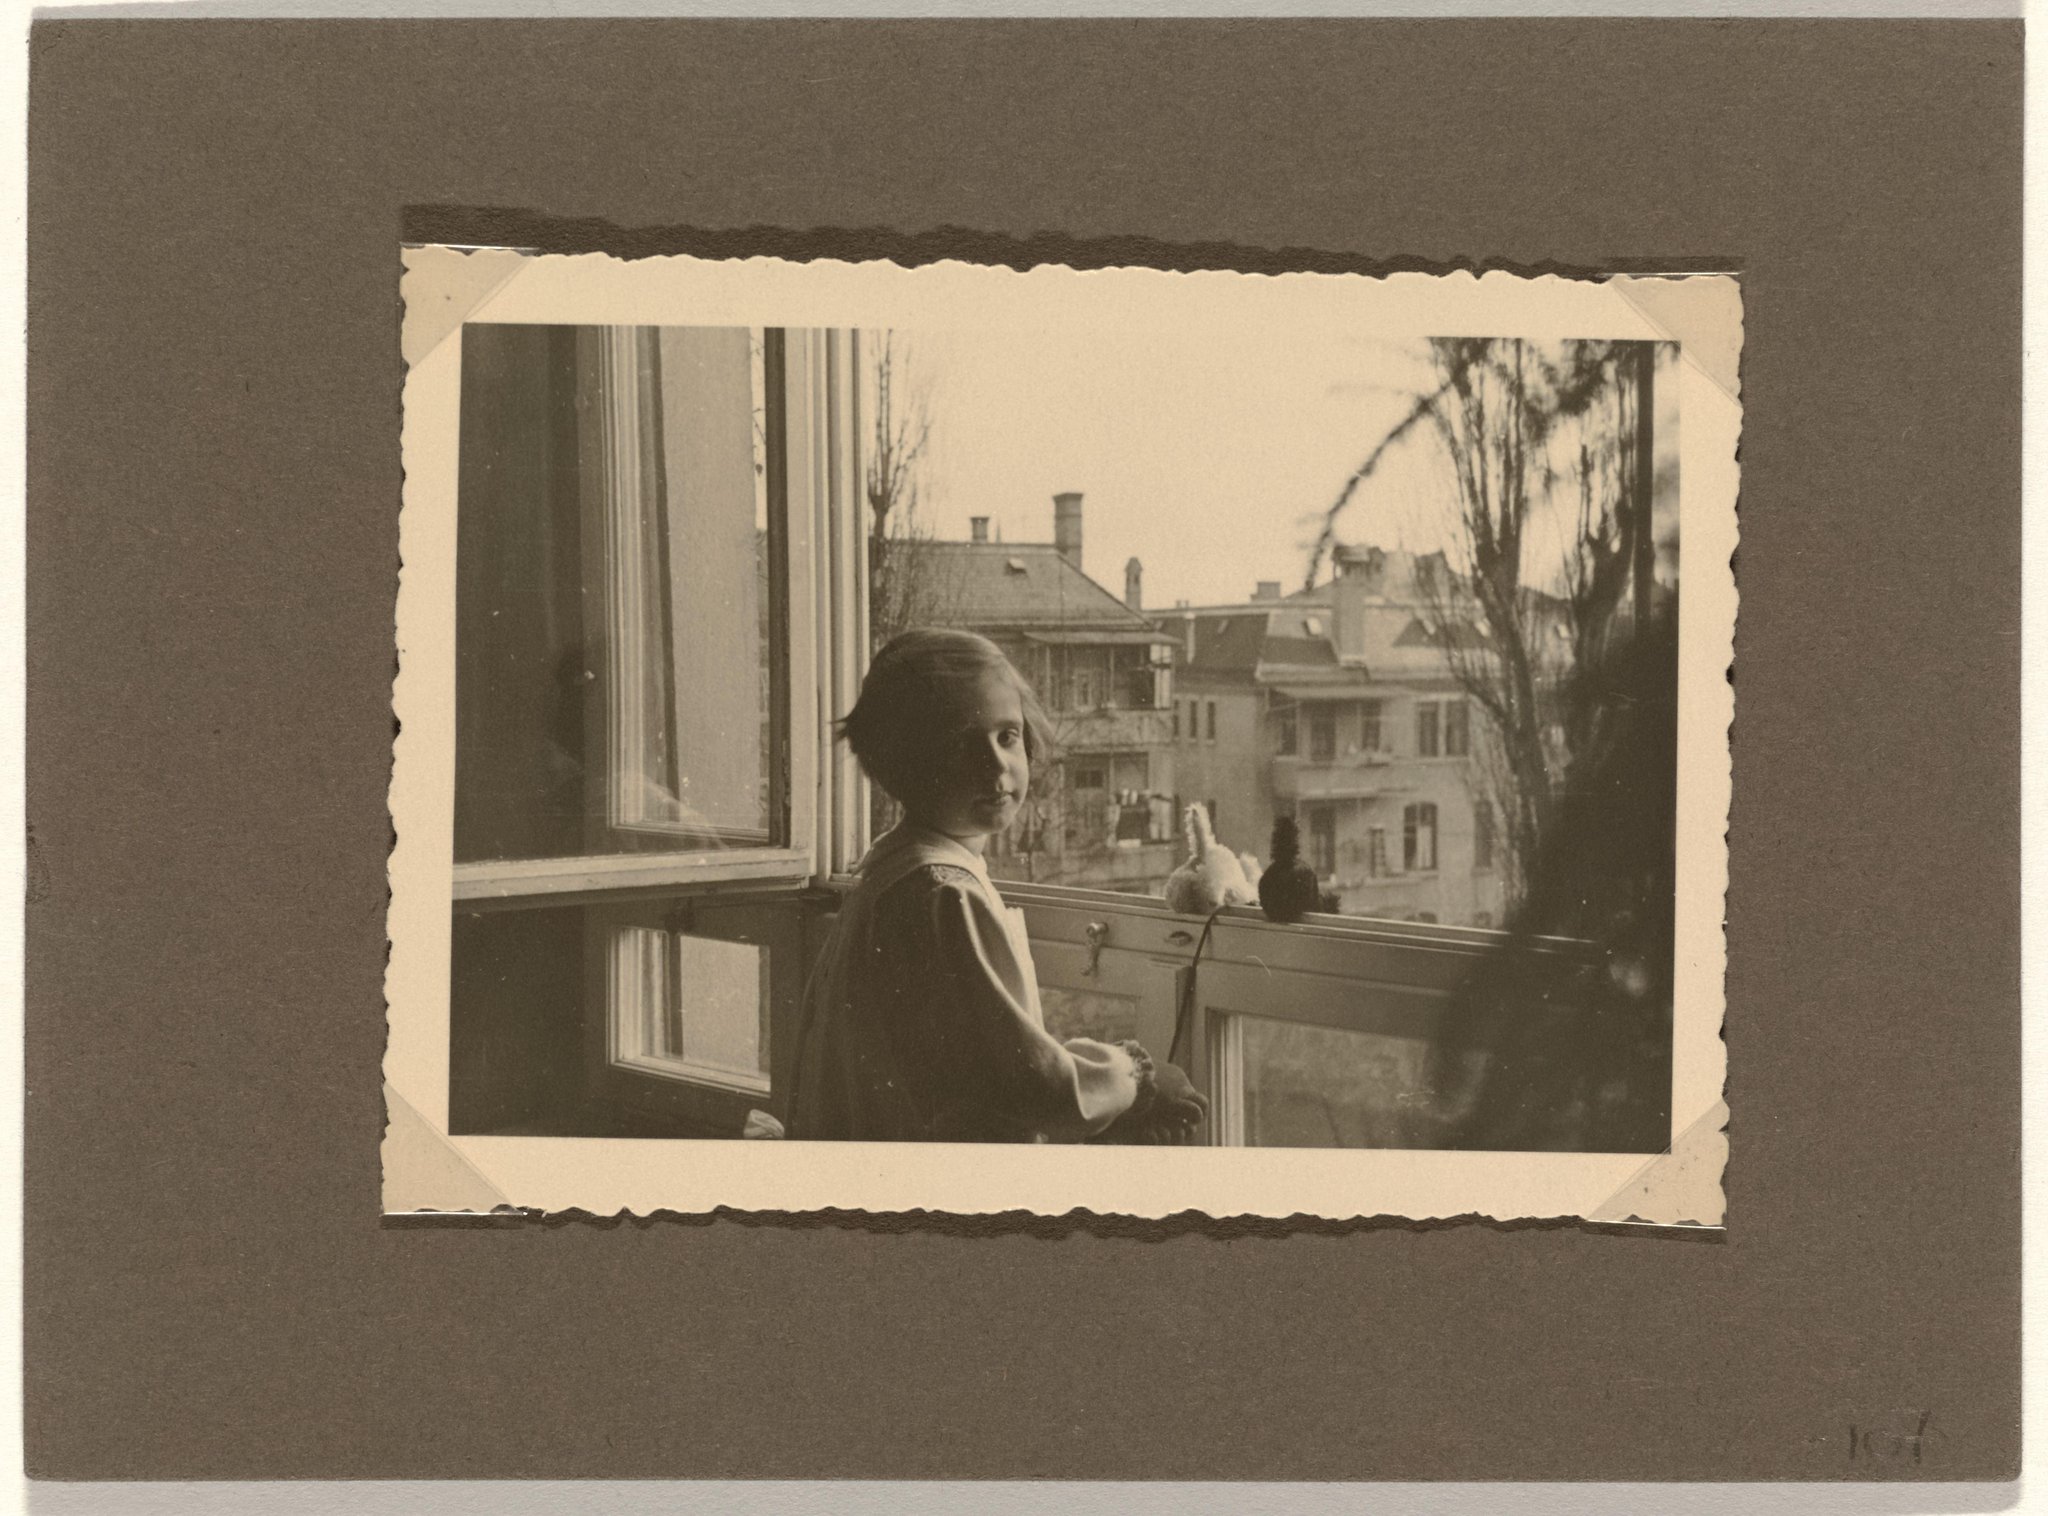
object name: photograph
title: Isabel Wachenheimer met pluche beesten bij een open raam, juni 1934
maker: Anonymous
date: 1906-1934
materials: photographic support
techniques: gelatin silver print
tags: leiden, isabel wachenheimer-elon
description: Isabel Wachenheimer met pluche beesten bij een open raam.